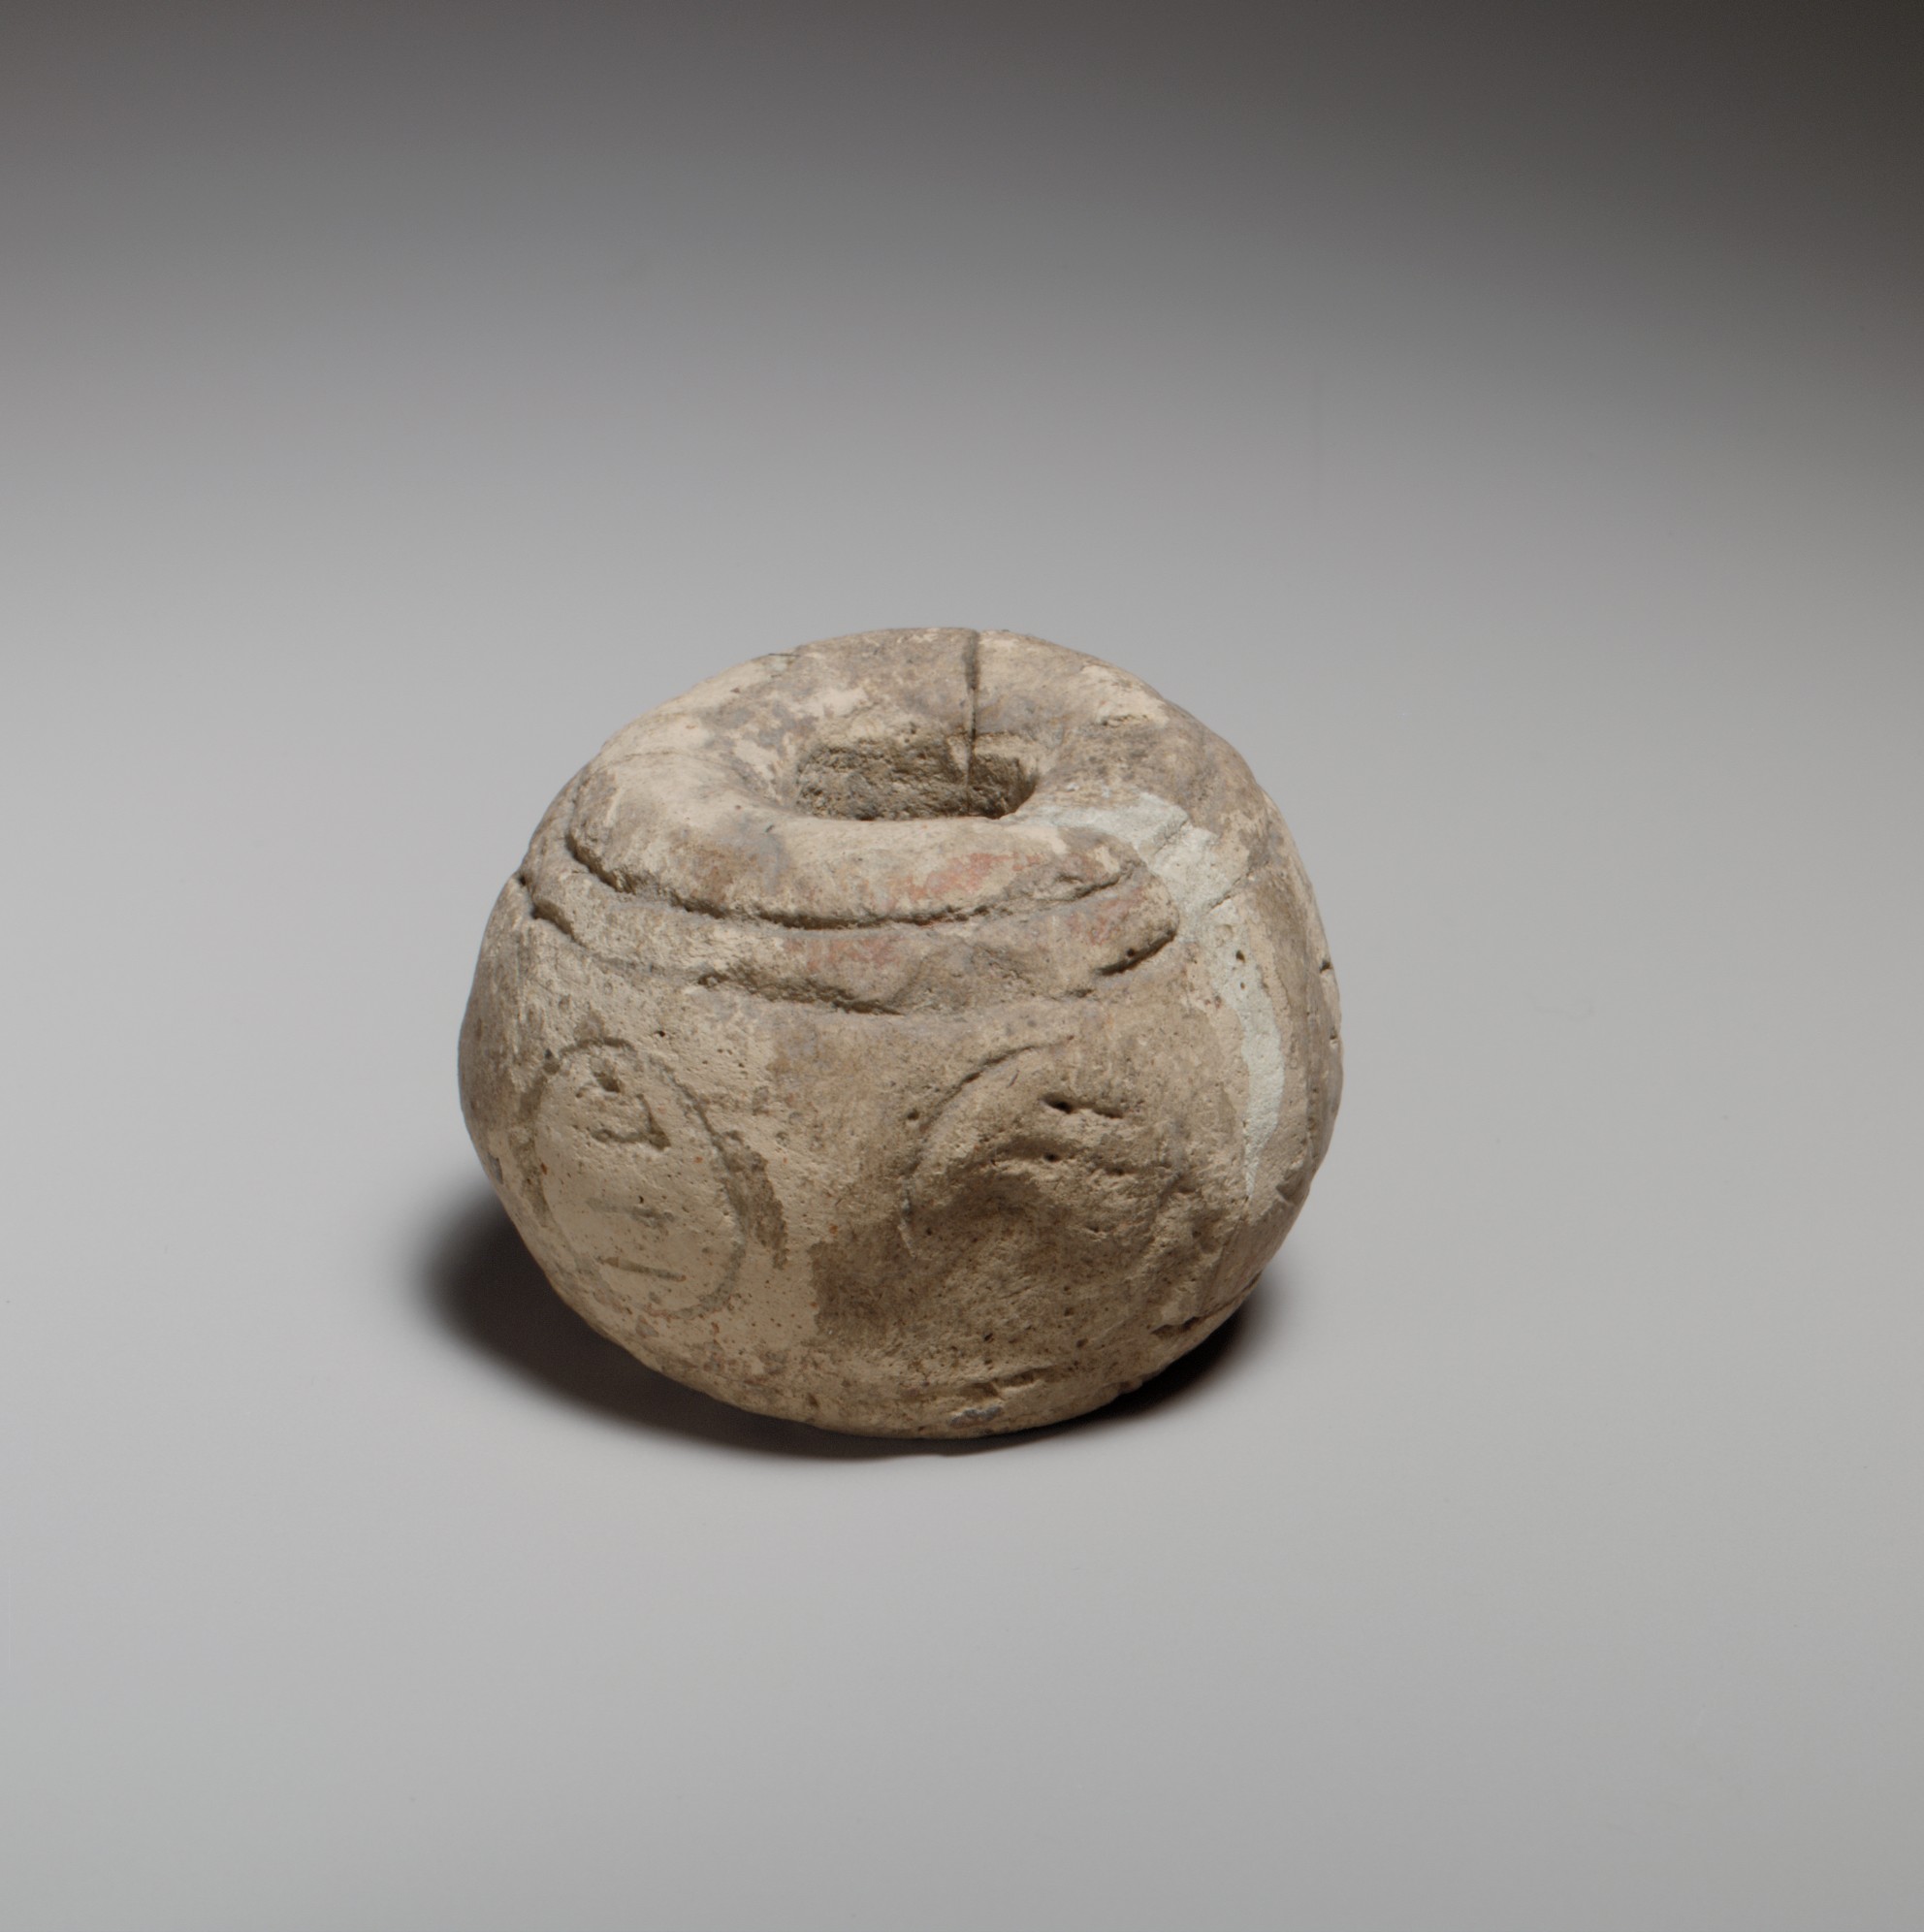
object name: spindle whorl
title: Spherical spindle-whorl with broad top and base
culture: cypriot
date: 2000-1725 BCE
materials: terracotta